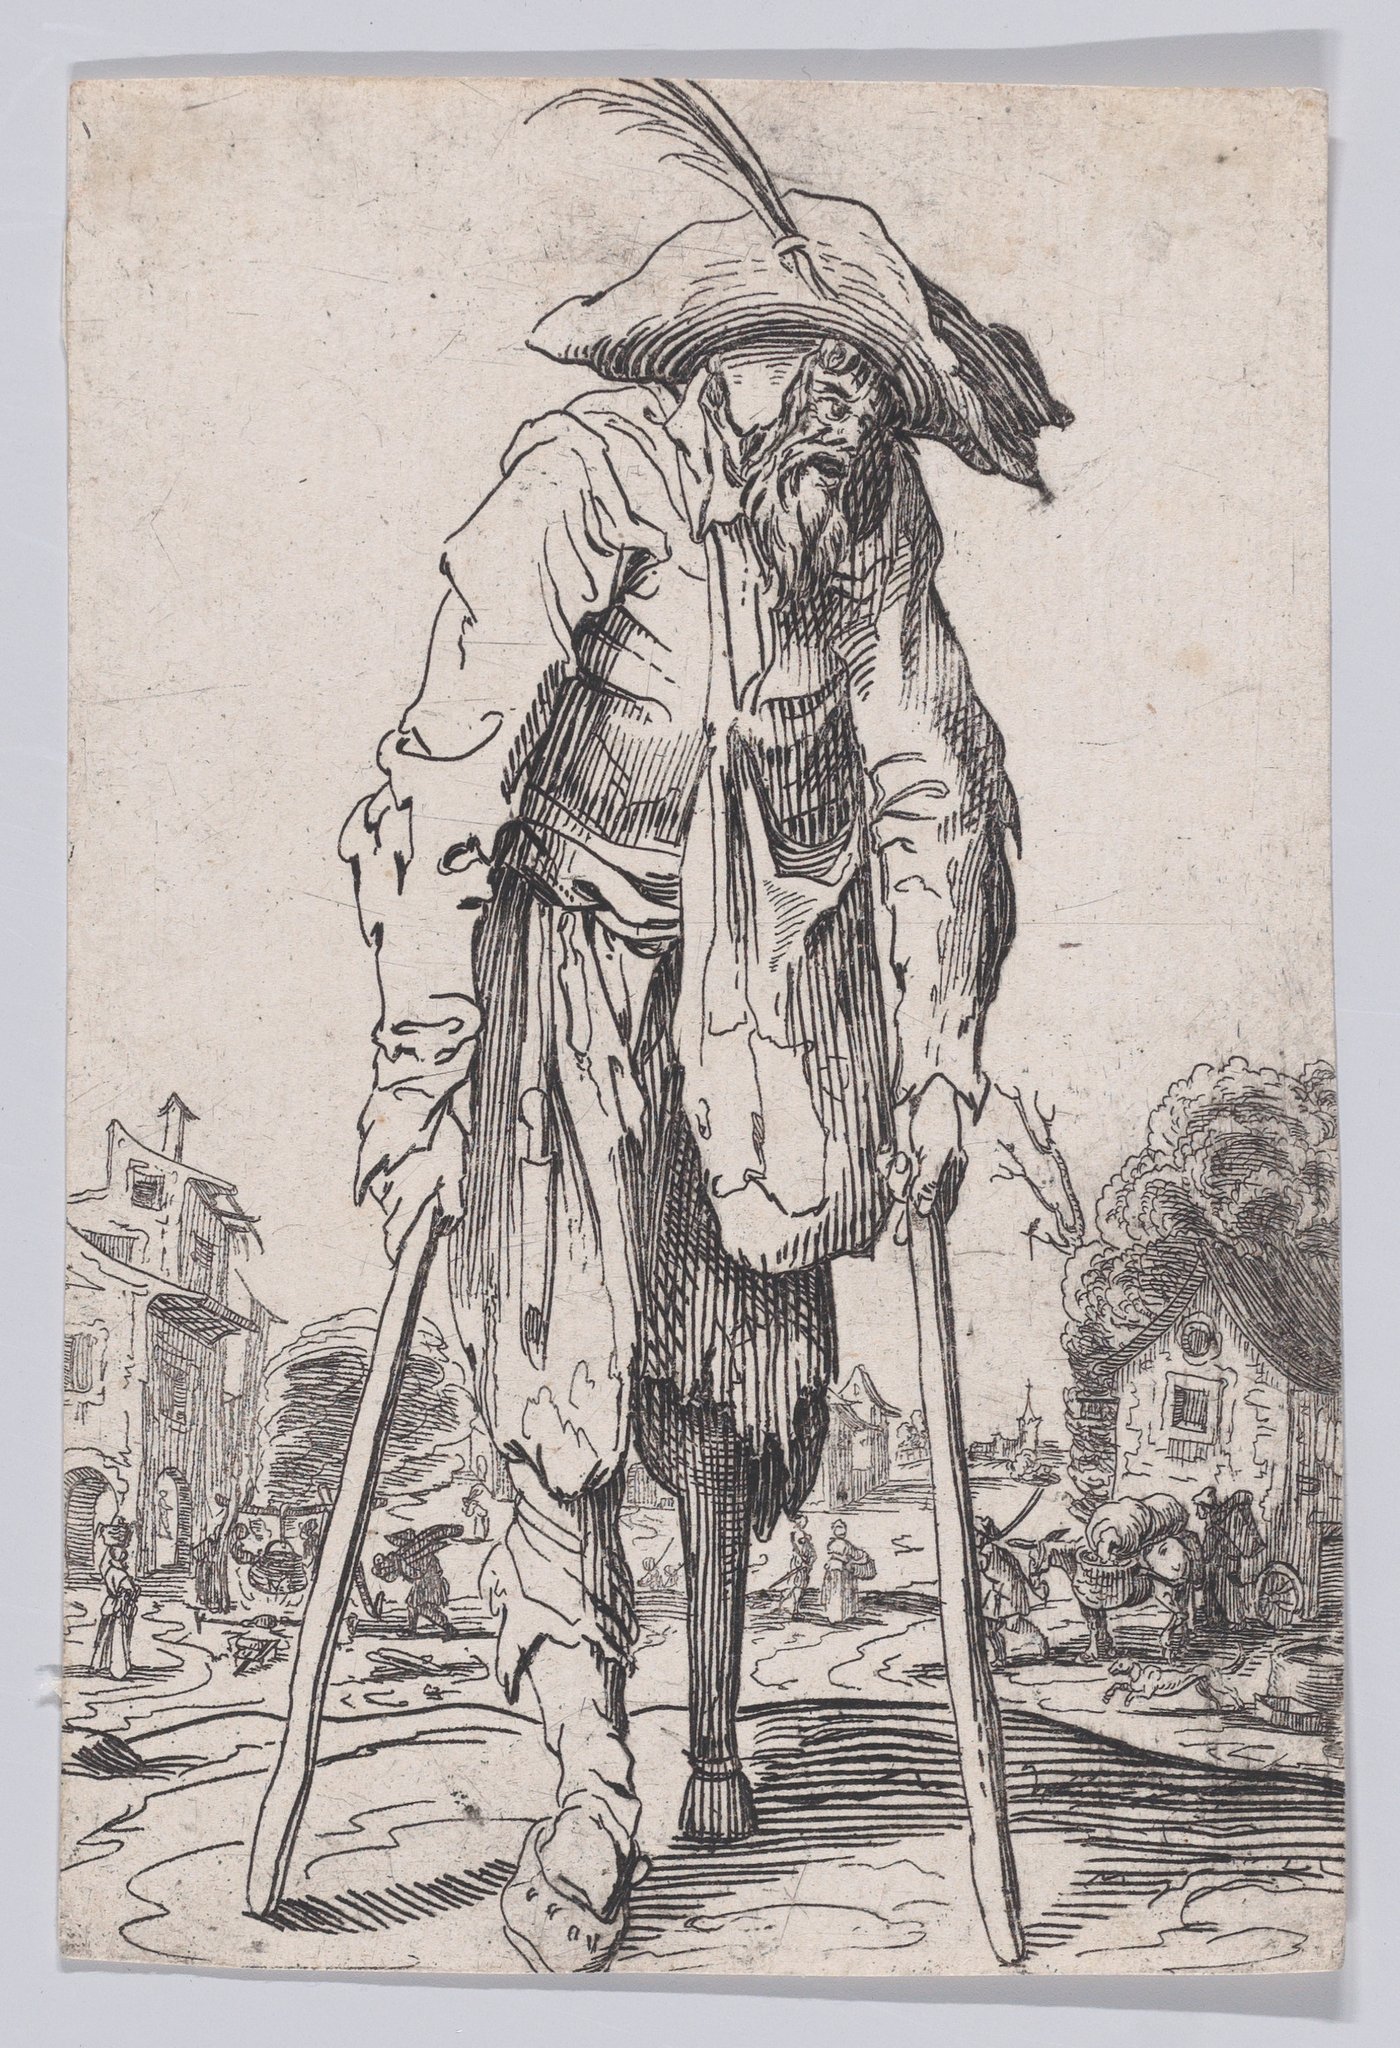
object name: print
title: Reverse Copy of Le Mendiant a la Jambe de Bois (The Beggar with the Wooden Leg), from "Les Gueux suite appelée aussi Les Mendiants, Les Baroni, ou Les Barons" (The Beggars, also called the Barons)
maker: Anonymous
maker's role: artist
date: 1601-1700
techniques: etching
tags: men